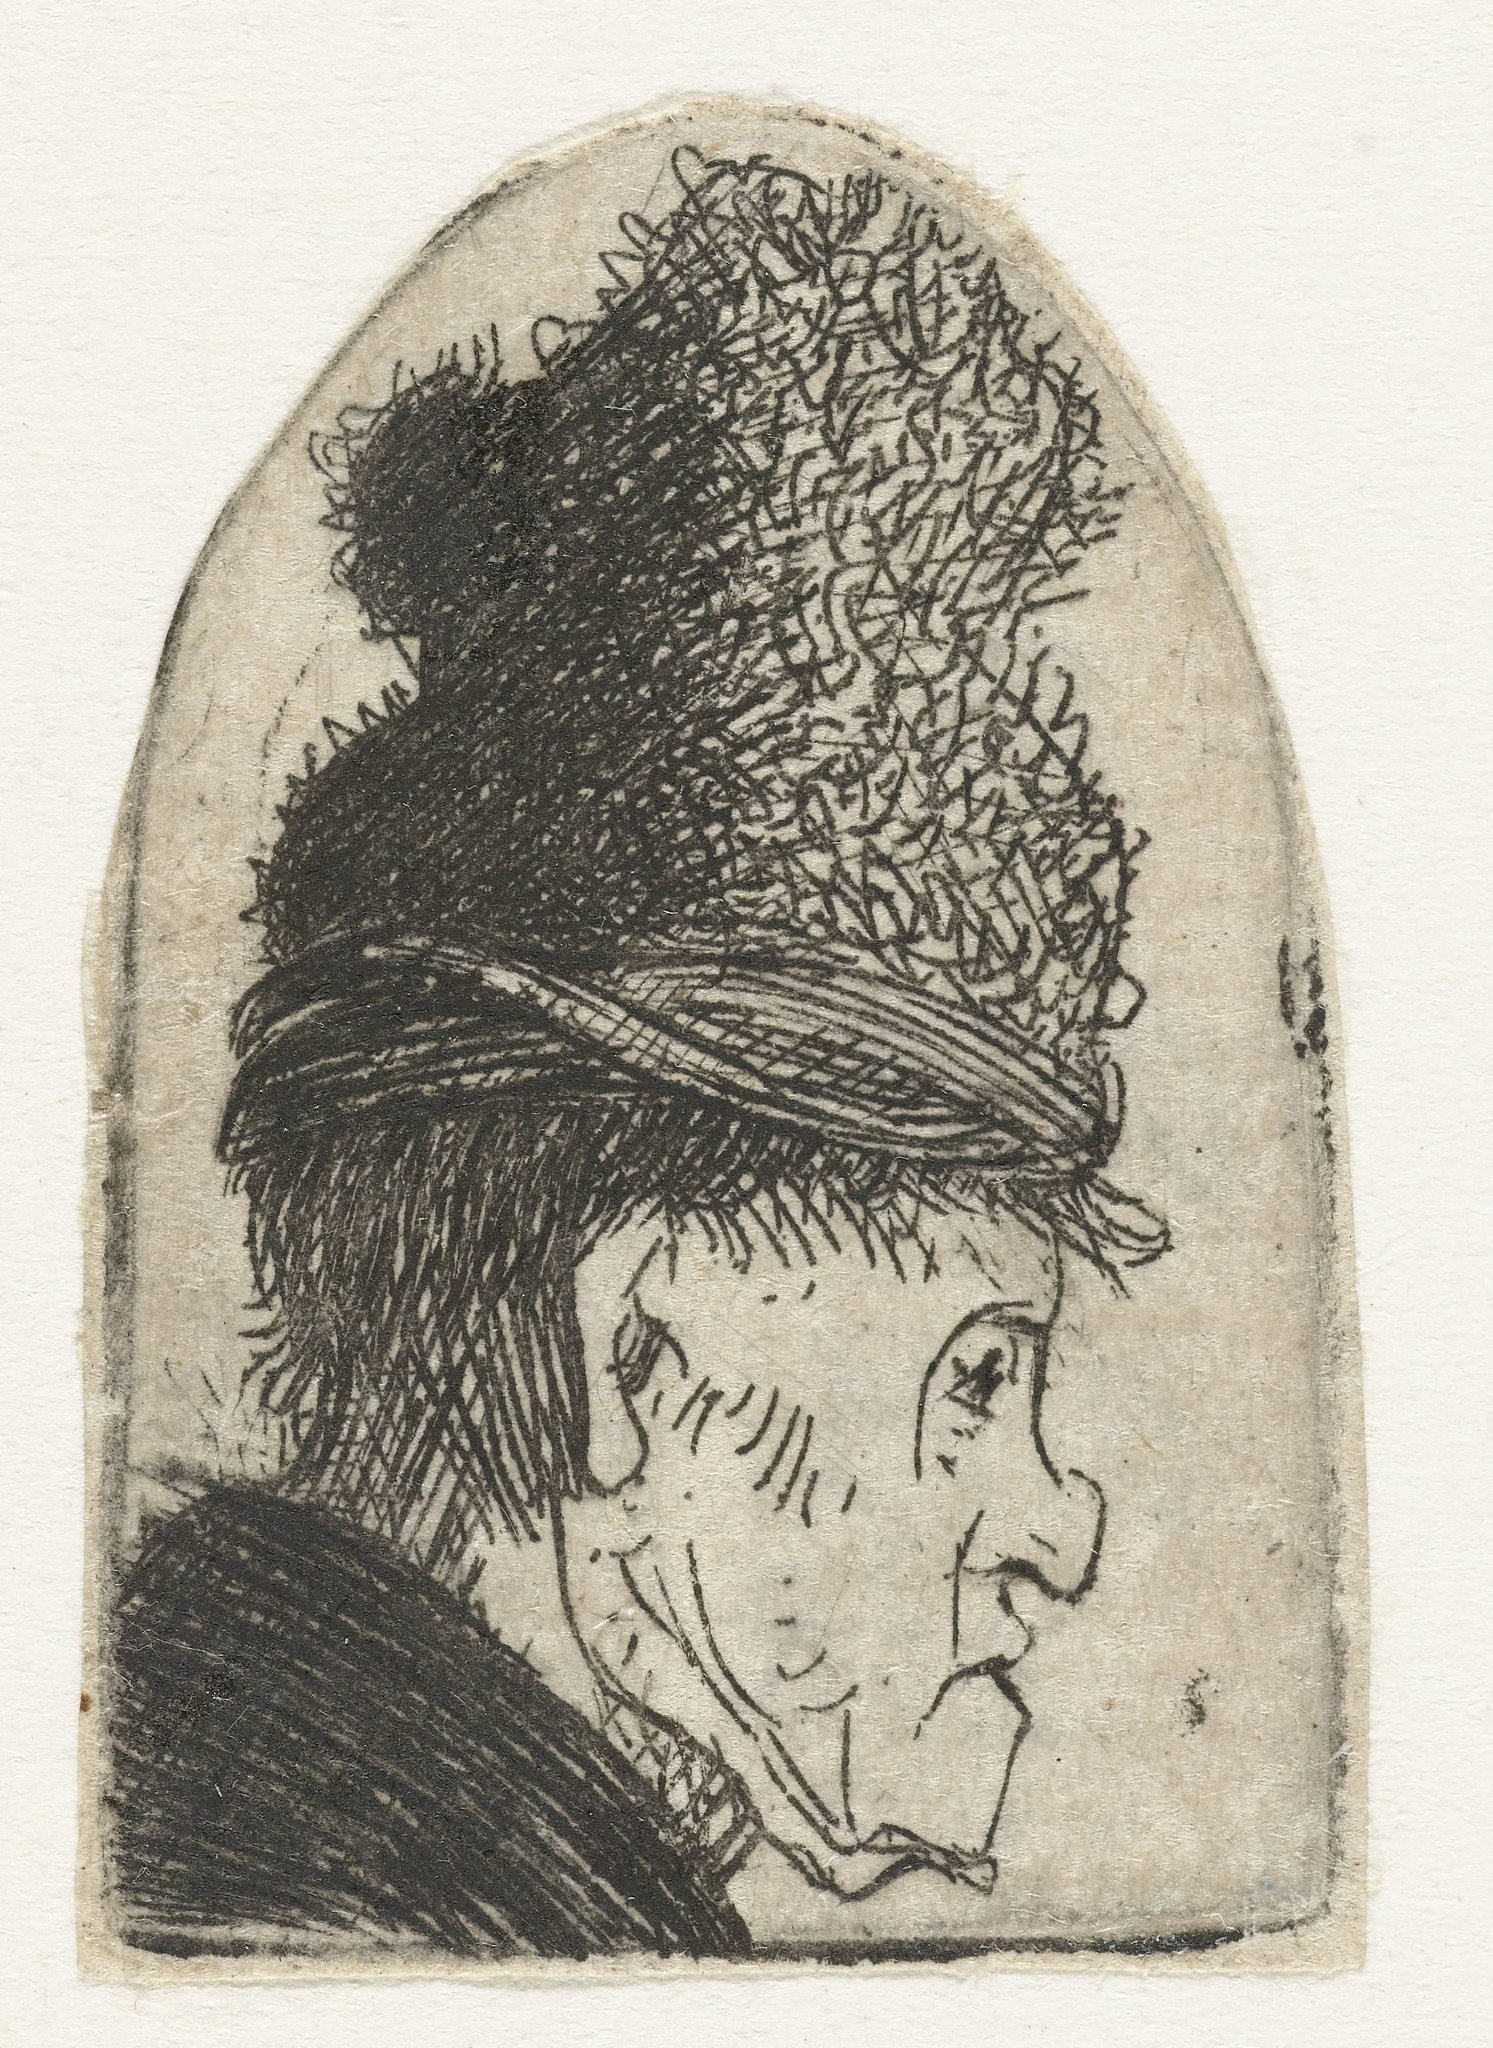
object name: print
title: Grotesque profile: man in a high cap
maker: rembrandt van rijn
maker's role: draughtsman, painter, print maker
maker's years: 1606-1669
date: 1629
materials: paper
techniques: etching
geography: netherlands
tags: adult man (+ sideview, profile)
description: A striking feature of these four prints is how small they are. Rembrandt must have found it difficult to hold the little copperplates to draw the composition in the etching ground. He is fascinated by the quirky hats. Some are so tall they beg the question whether he depicted them faithfully or somewhat exaggerated their height.